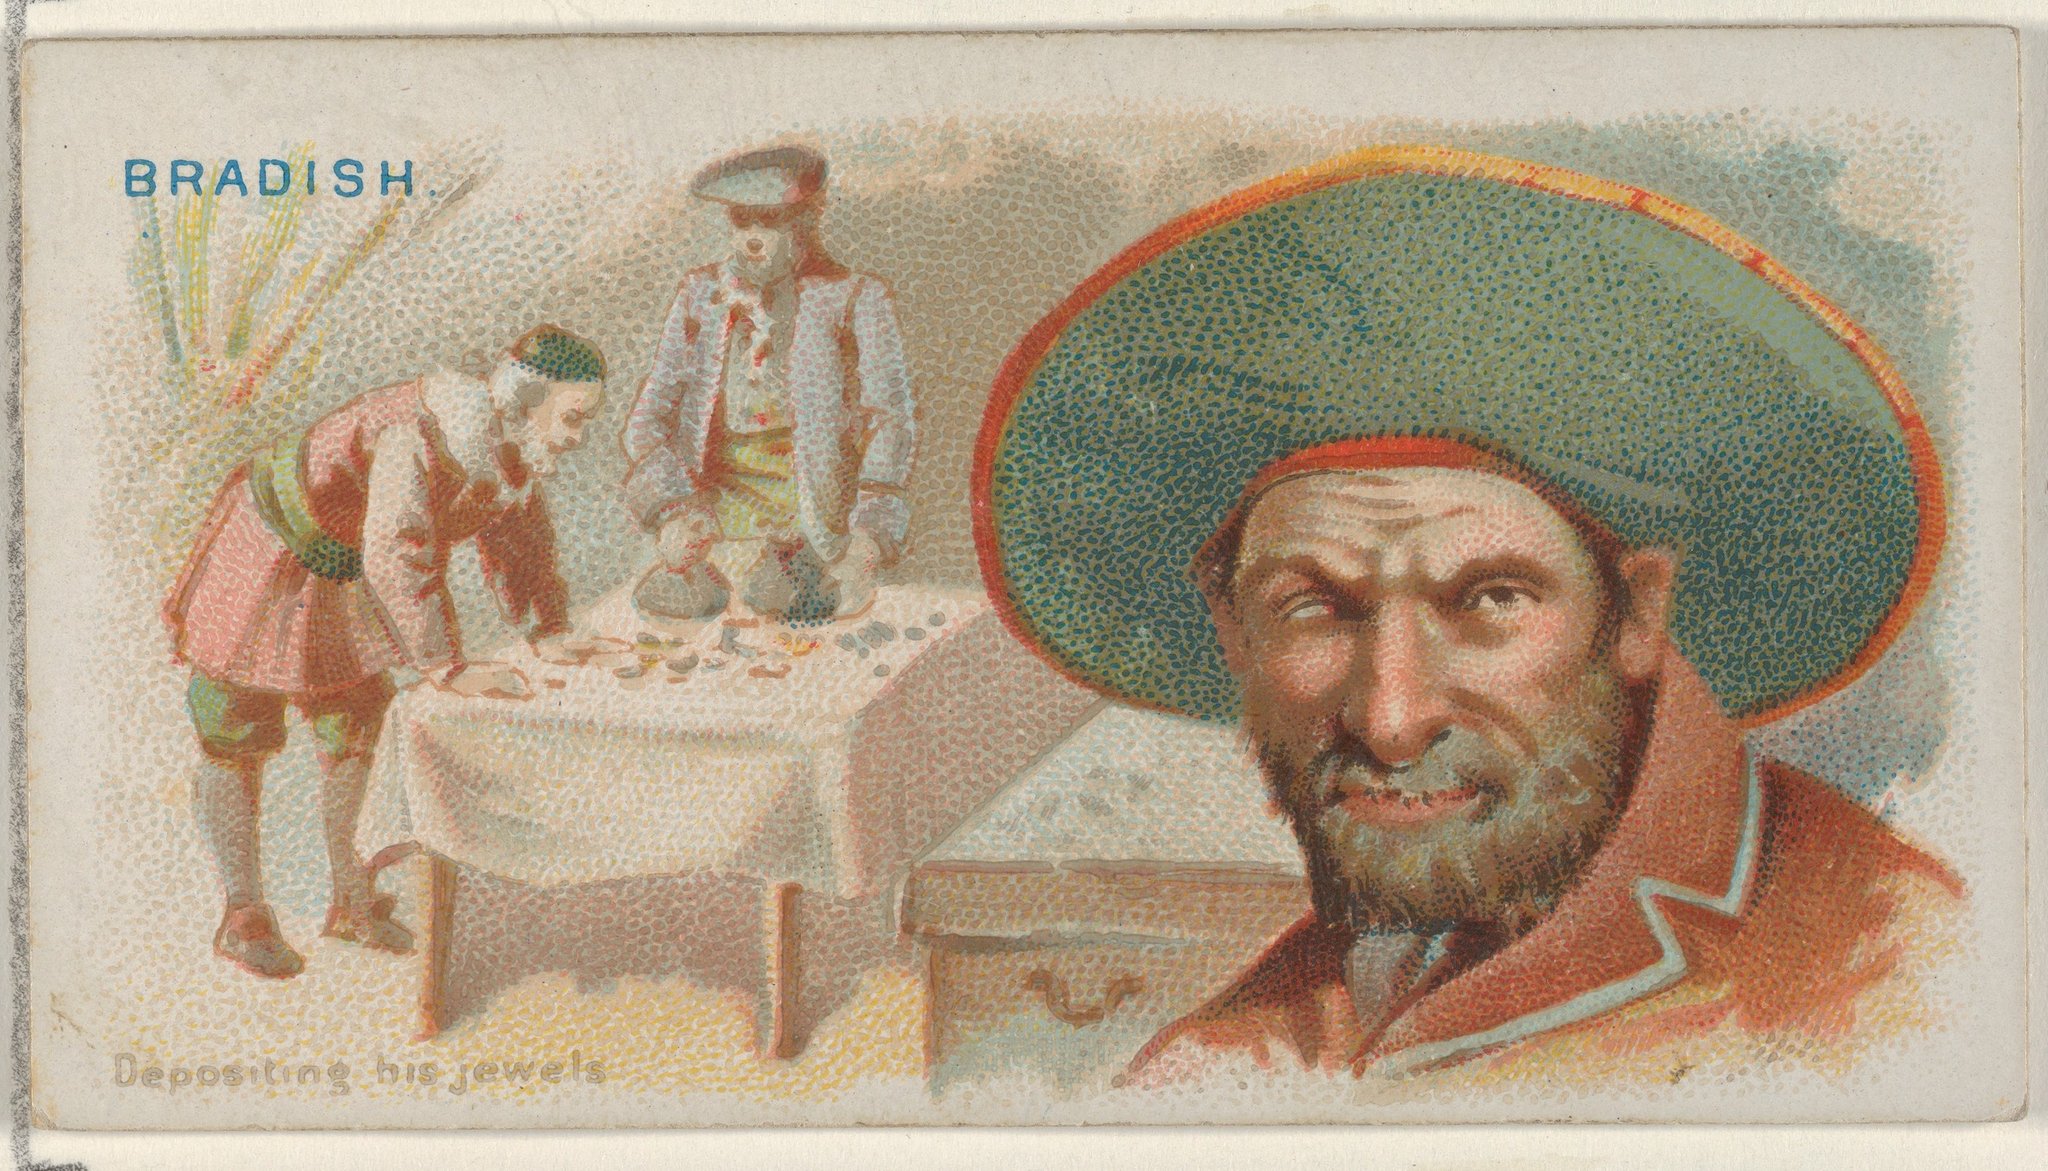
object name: print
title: Joseph Bradish, Depositing His Jewels, from the Pirates of the Spanish Main series (N19) for Allen & Ginter Cigarettes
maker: allen & ginter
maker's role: publisher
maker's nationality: american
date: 1888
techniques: color lithograph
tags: men